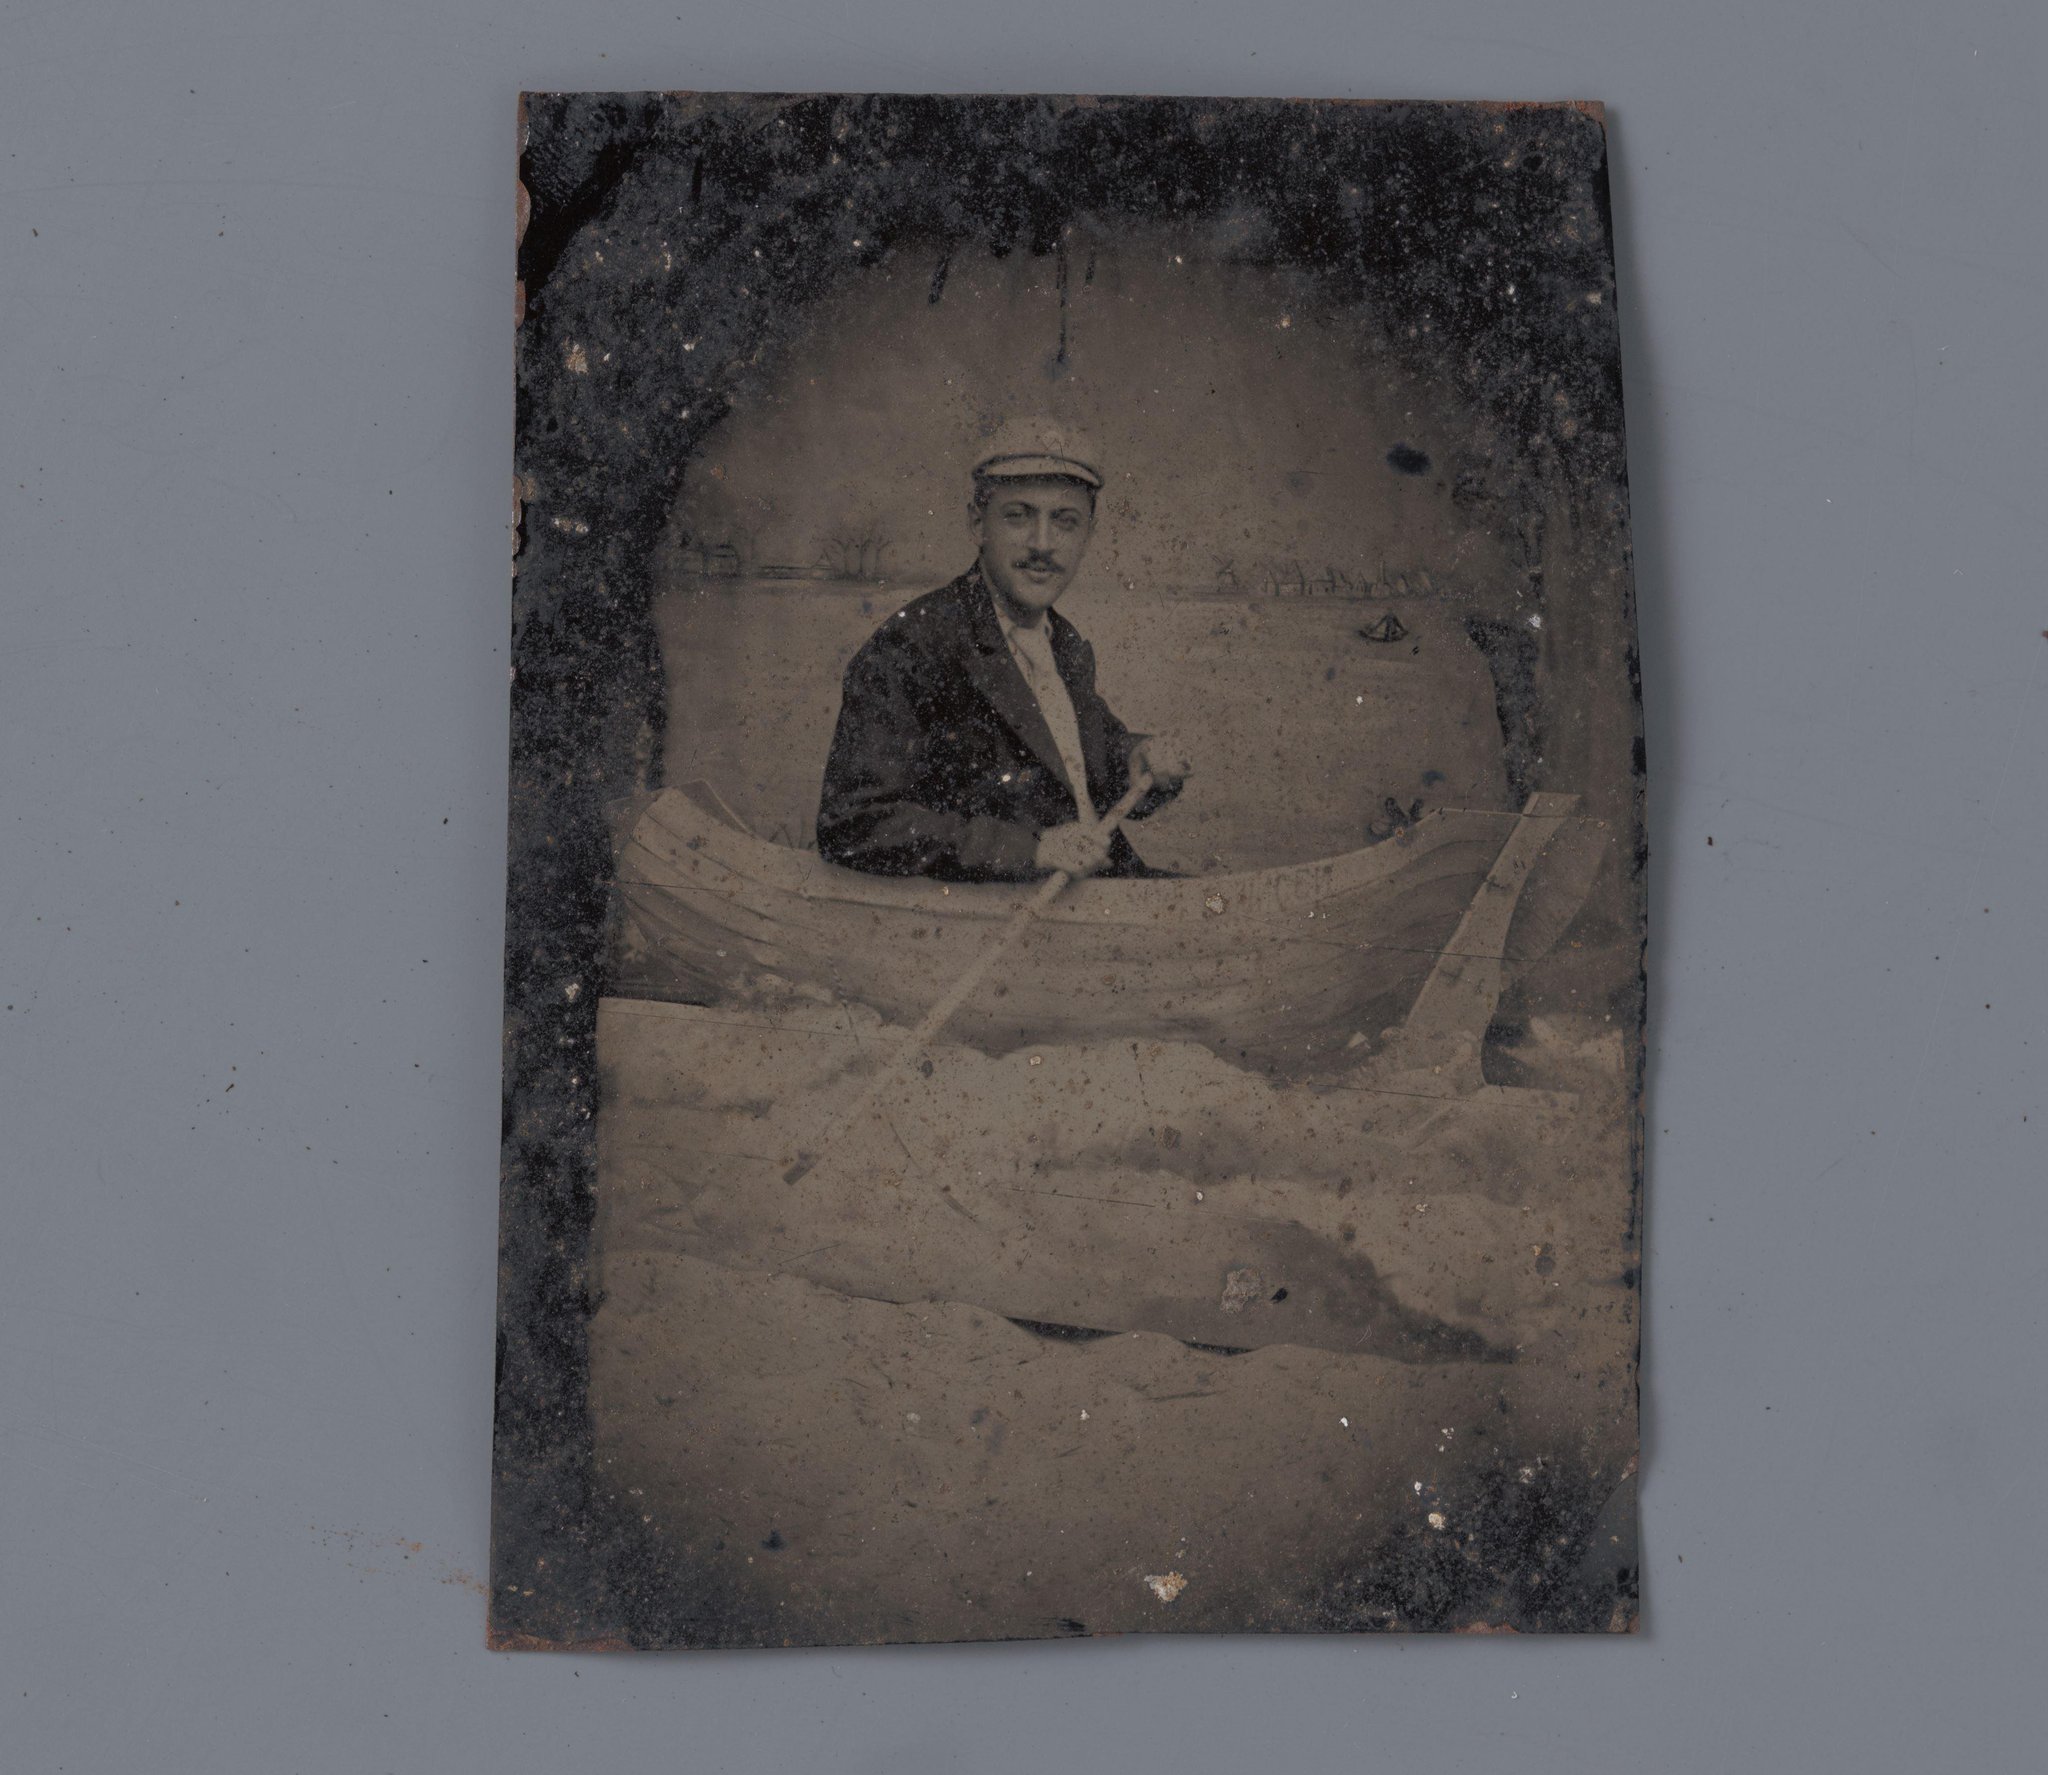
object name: photograph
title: Portret van een onbekende jonge man in roeiboot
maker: Anonymous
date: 1855-1900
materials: iron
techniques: ferrotyping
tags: historical persons, youth, adolescent, rowing-boat, canoe, etc.